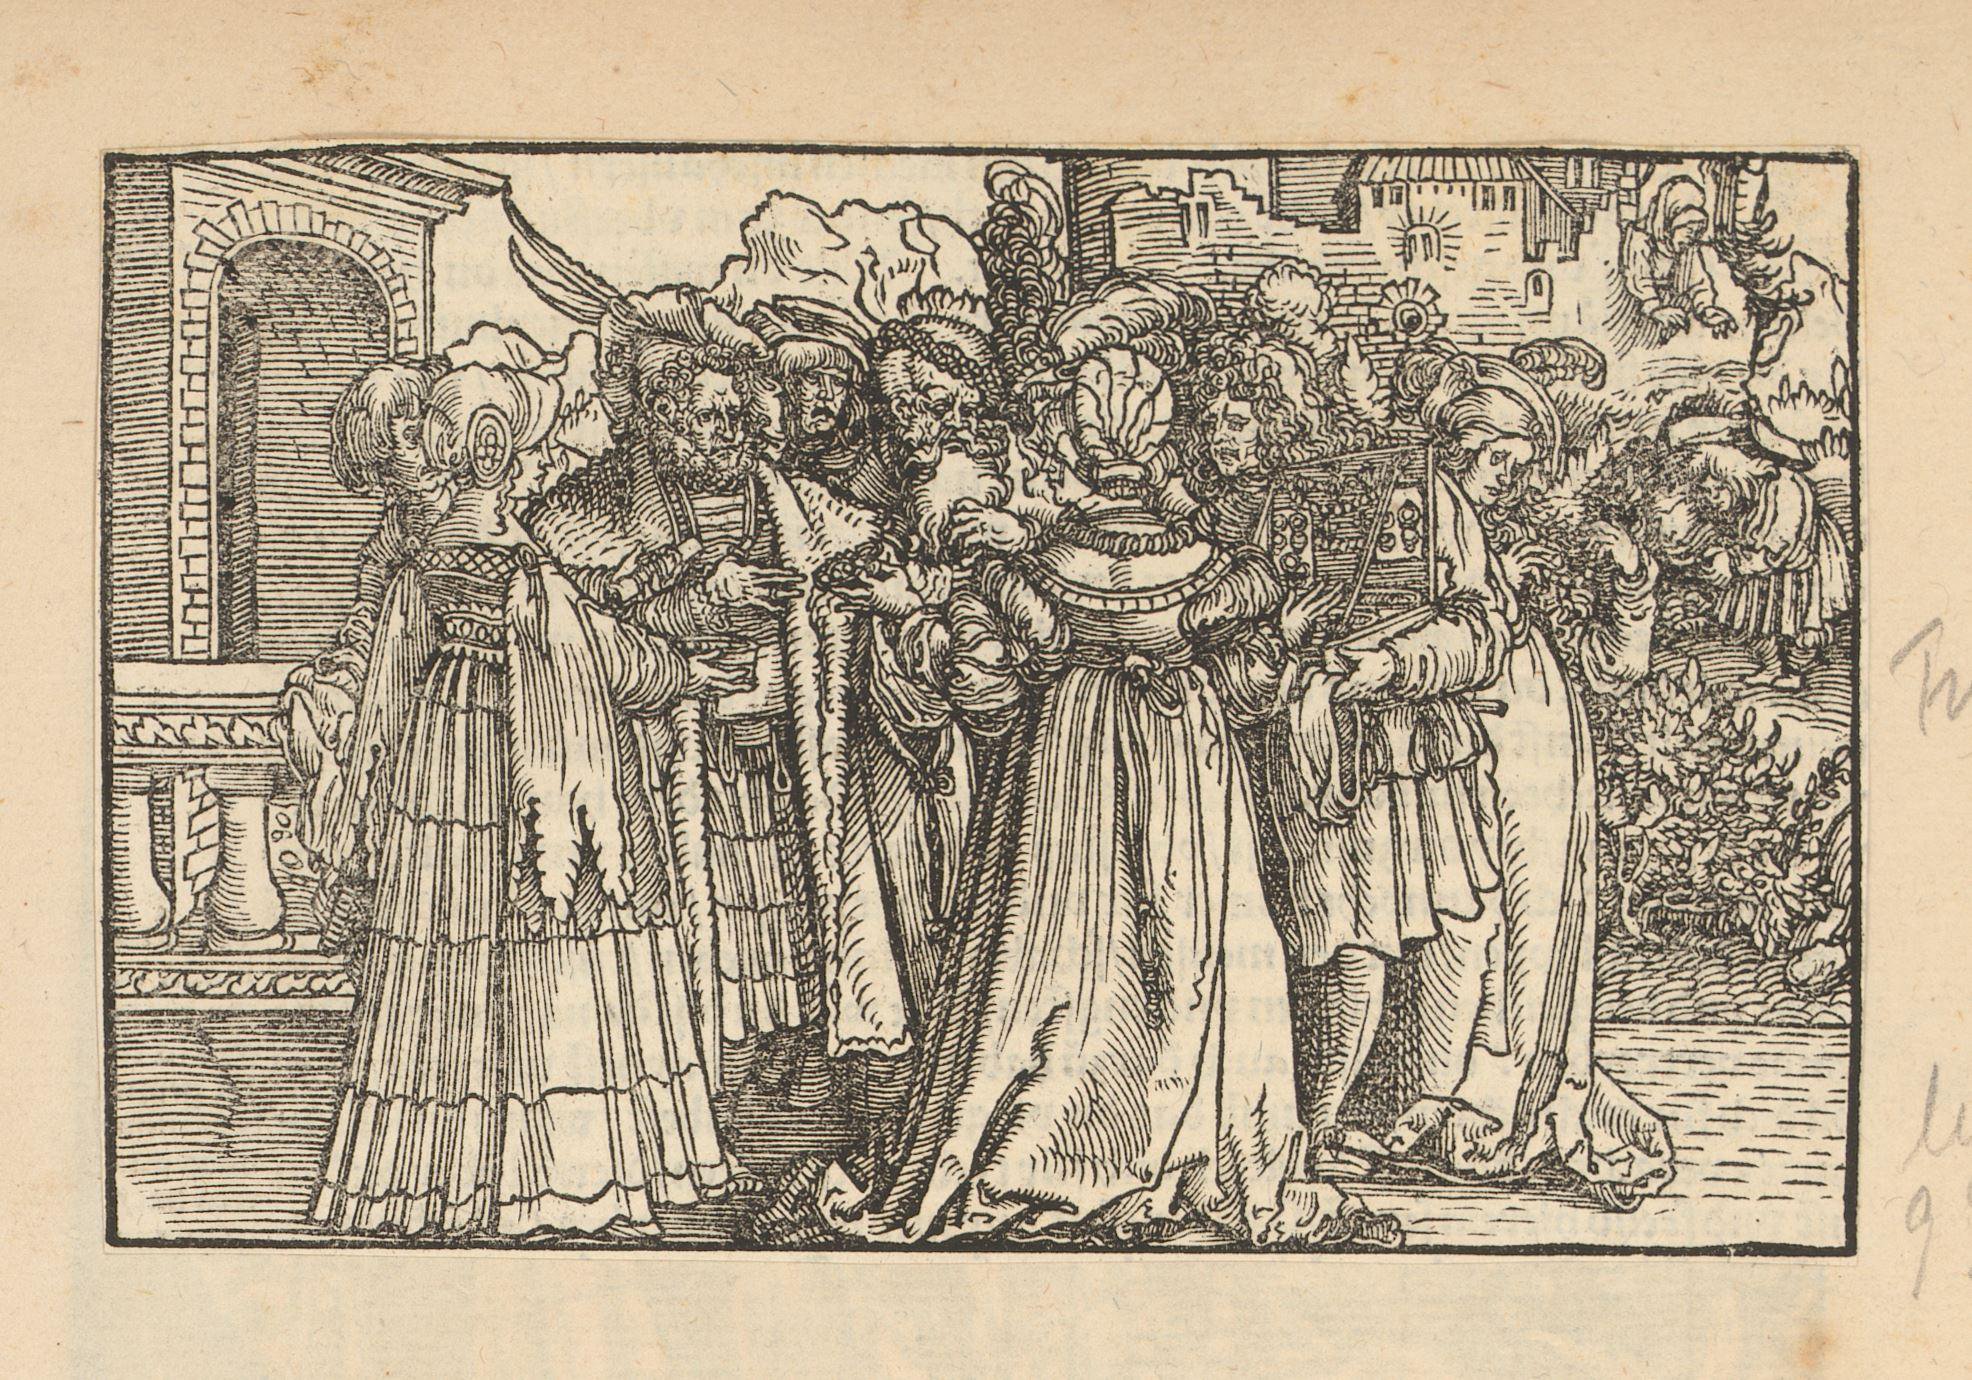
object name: book illustration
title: Elegant gezelschap koopt sieraden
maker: Anonymous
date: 1514-1532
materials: paper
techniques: letterpress printing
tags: visiting; receiving guests; elegant company, selling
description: Deze prent is gebruikt in: Petrarca, Francesco. Von der Artzney bayder Glück, des guten und widerwertigen: unnd weß sich ain yeder inn Gelück und Unglück halten sol (...). Augsburg: Heinrich Steiner, 1532. Deze uitgave is ook bekend onder de titel 'Trostspiegel in Glück und Unglück'.